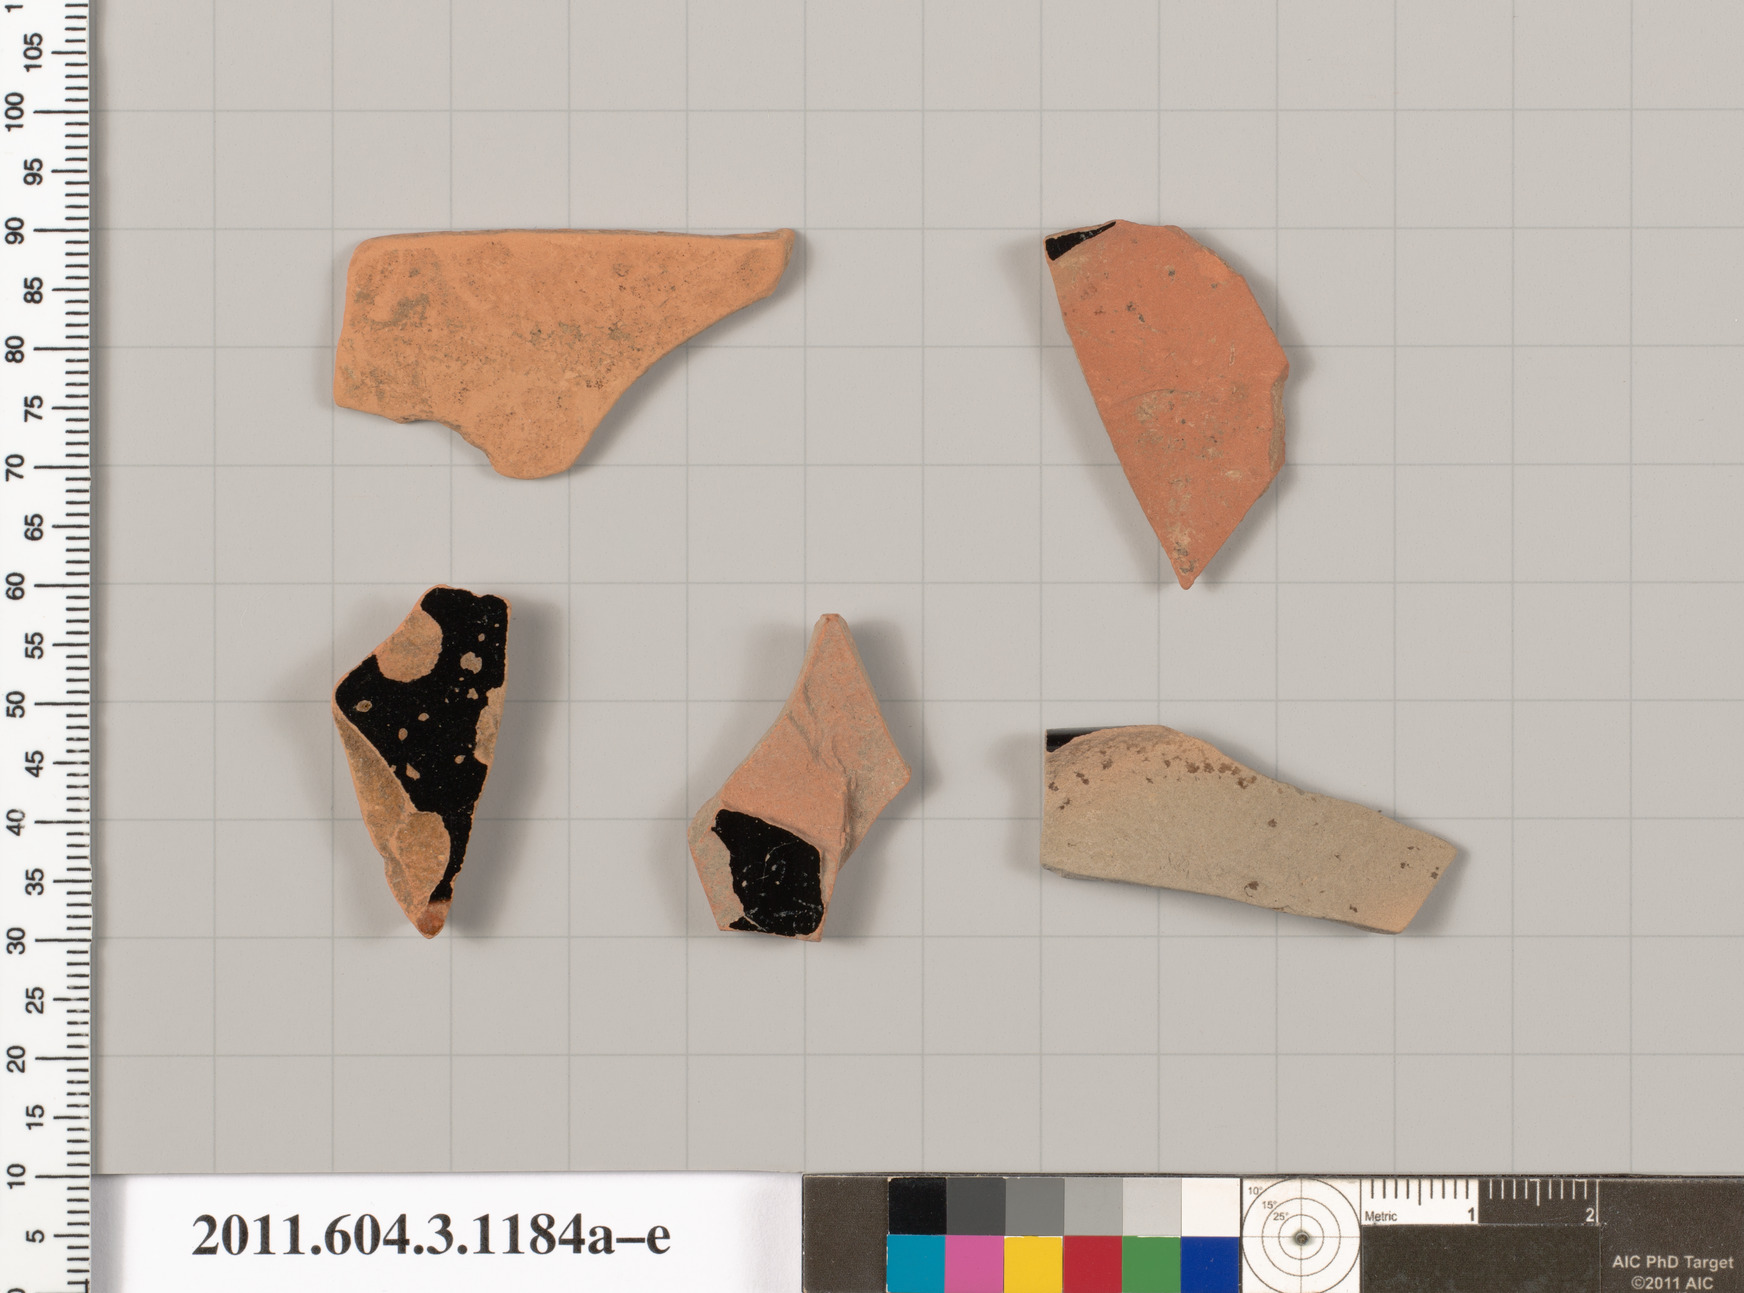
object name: mastoid or kyathos fragment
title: Terracotta fragments of mastoids (drinking cups with narrow base) or kyathoi (cup-shaped ladles)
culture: greek, attic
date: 534-468 BCE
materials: terracotta